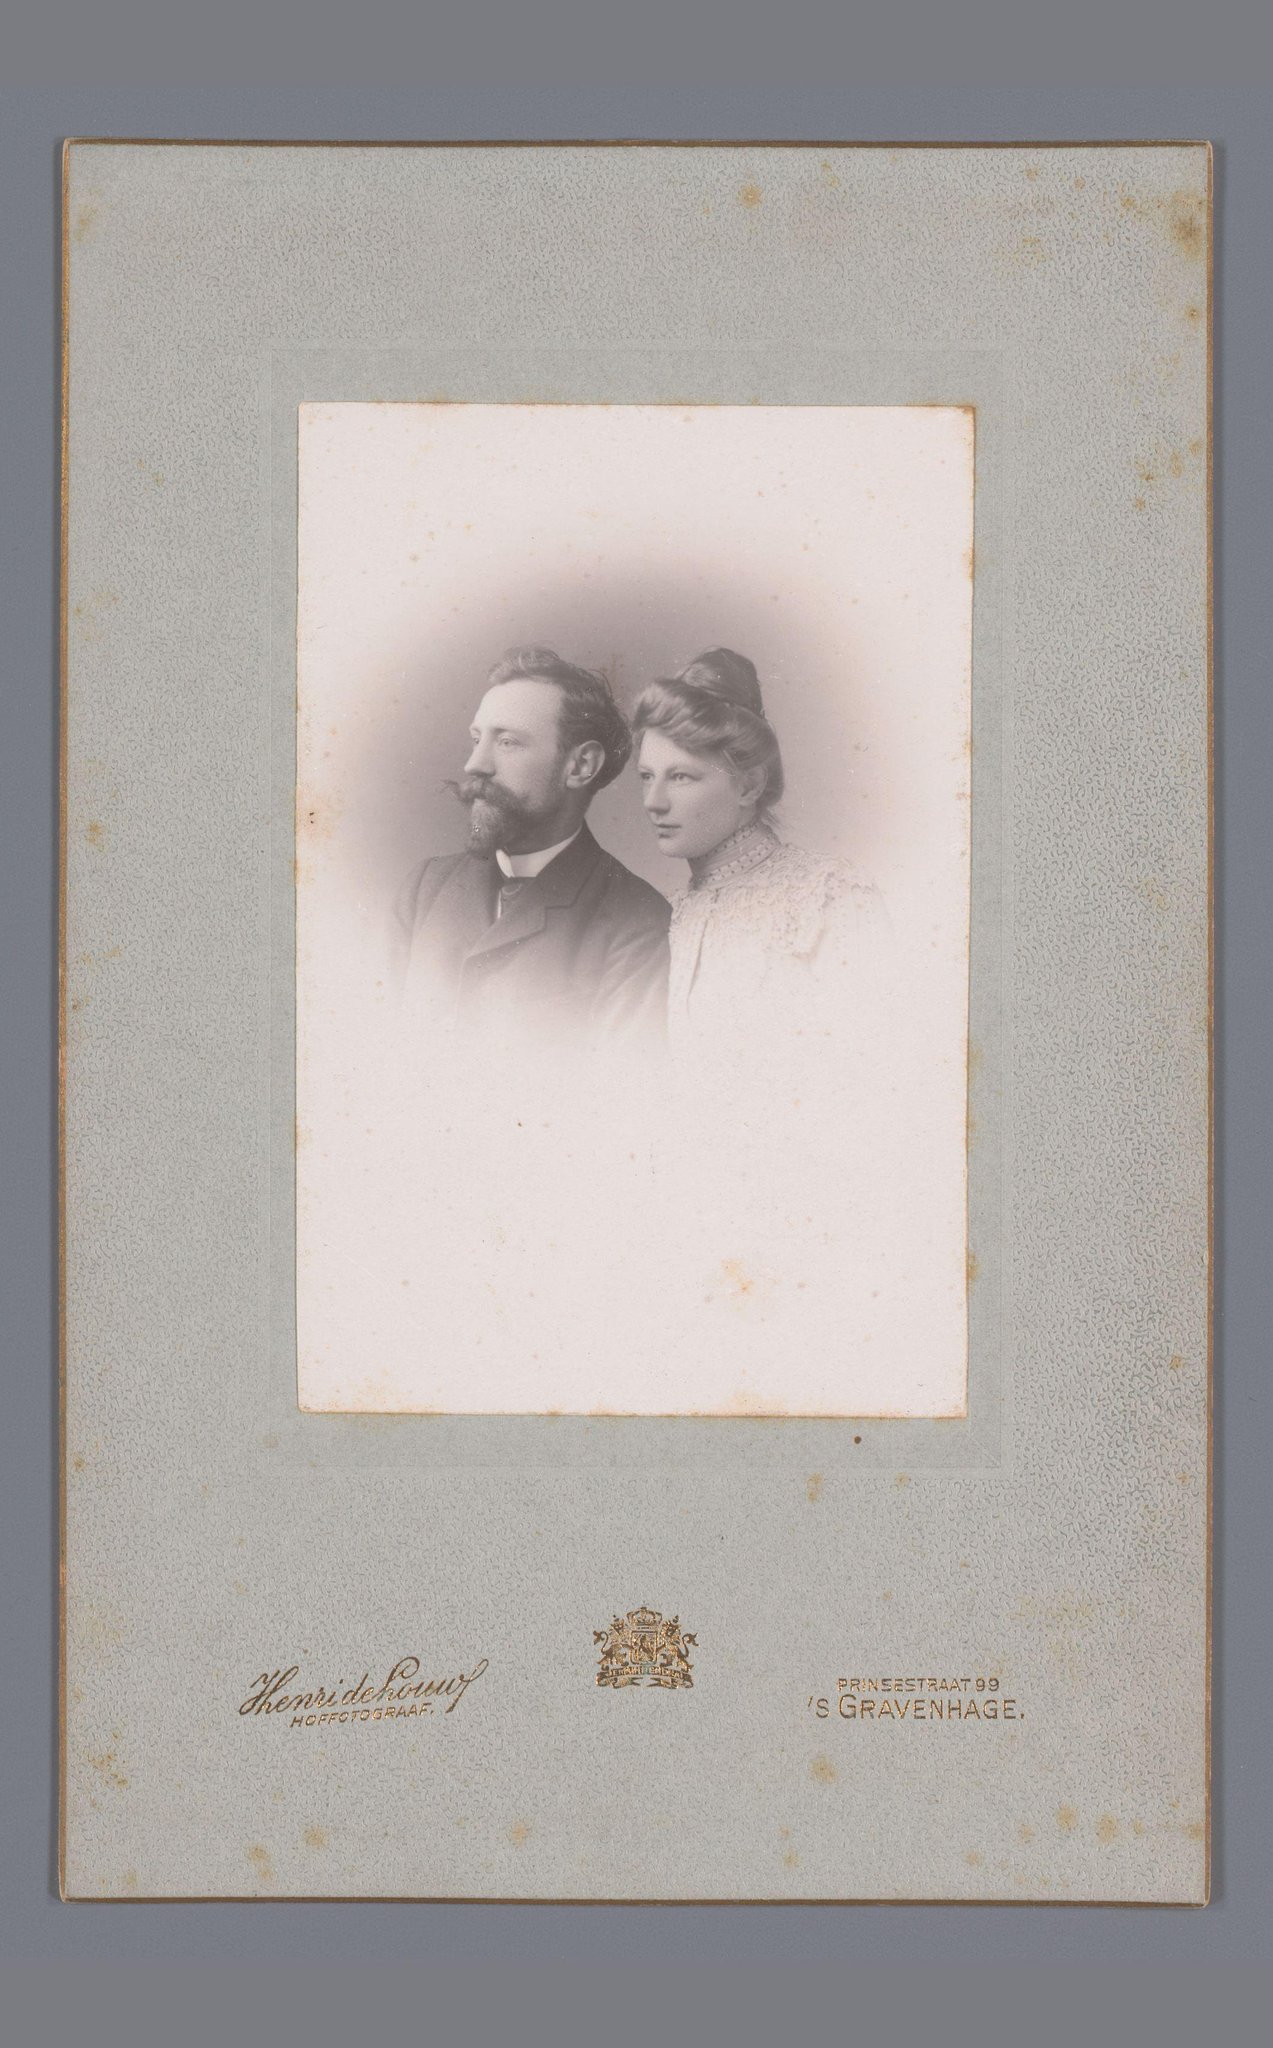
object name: cabinet photograph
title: Portret van Henk en Rich Holsboer Eschauzier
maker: henri de louw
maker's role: fotograaf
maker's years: 1851-1944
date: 1871-1927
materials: cardboard, photographic support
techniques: collodion silver print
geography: the hague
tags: historical persons, the hague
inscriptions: annotation: ‘Oom Henk en tante Rich Holsboer-Eschauzier’